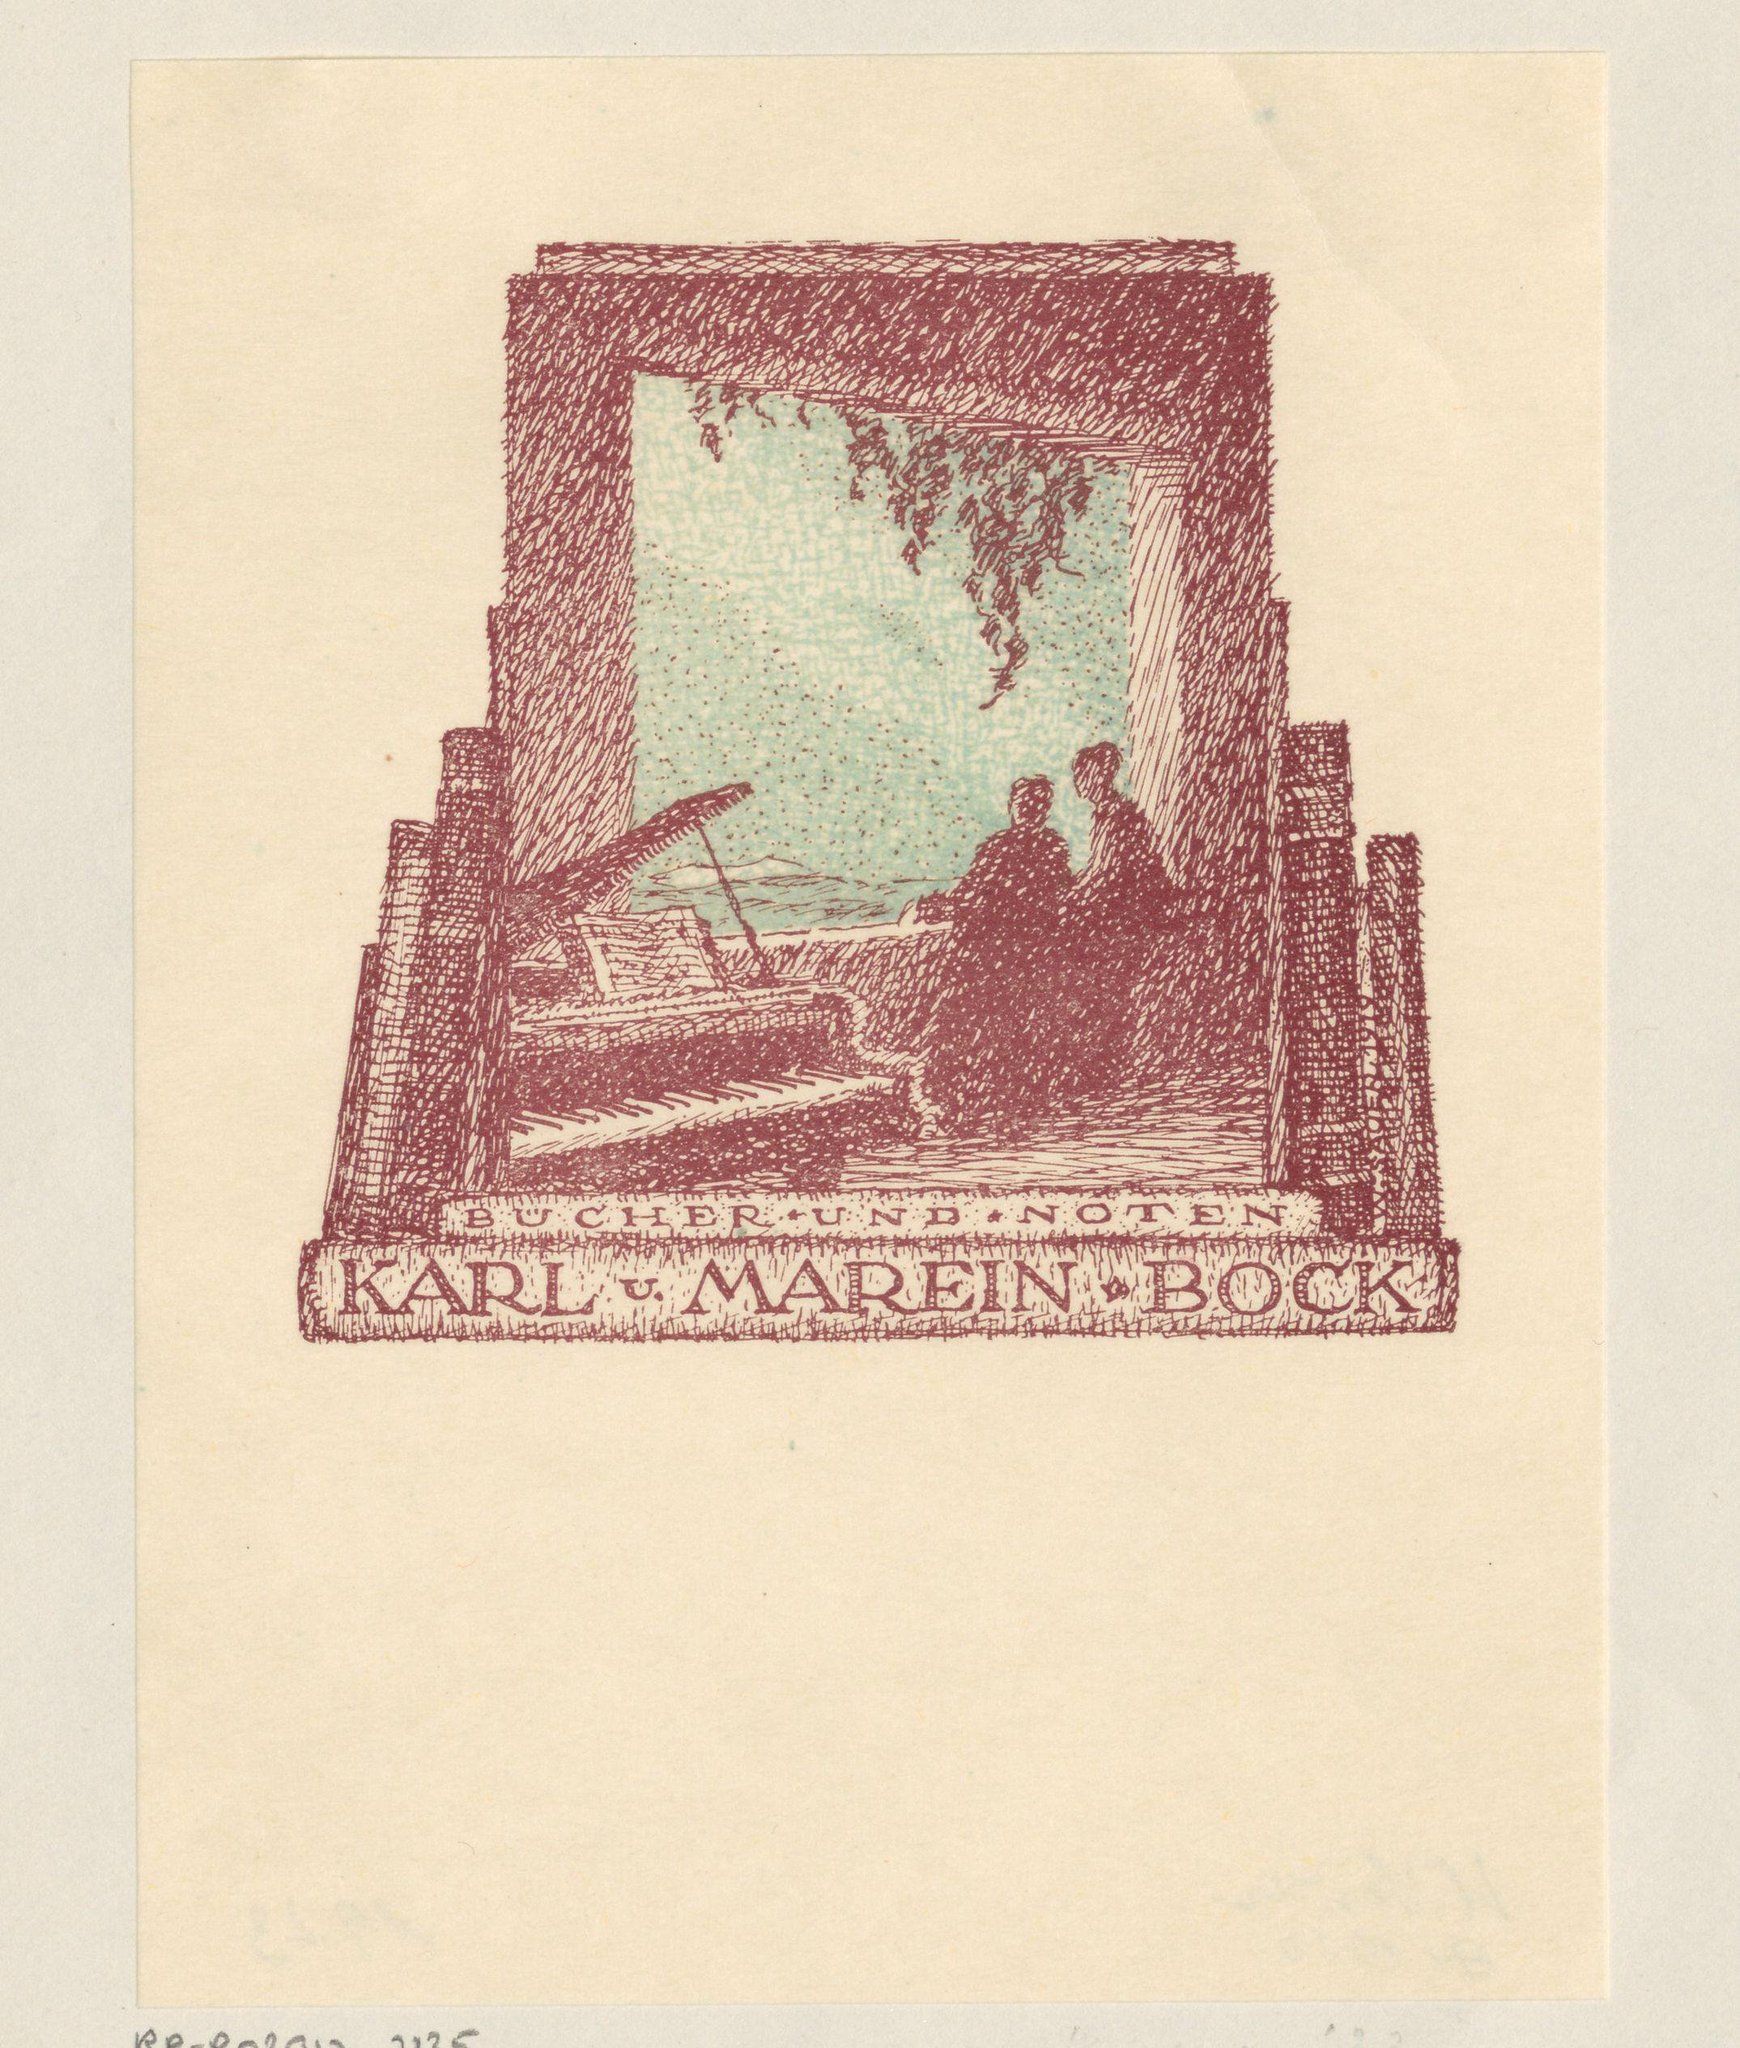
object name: bookplate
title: Ex libris van Karl en Marein Bock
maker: wilhelm sauer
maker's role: print maker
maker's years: 1892-1930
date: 1923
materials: paper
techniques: lithograph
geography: austria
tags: karl bock, sitting figure, grand piano, book, closed window